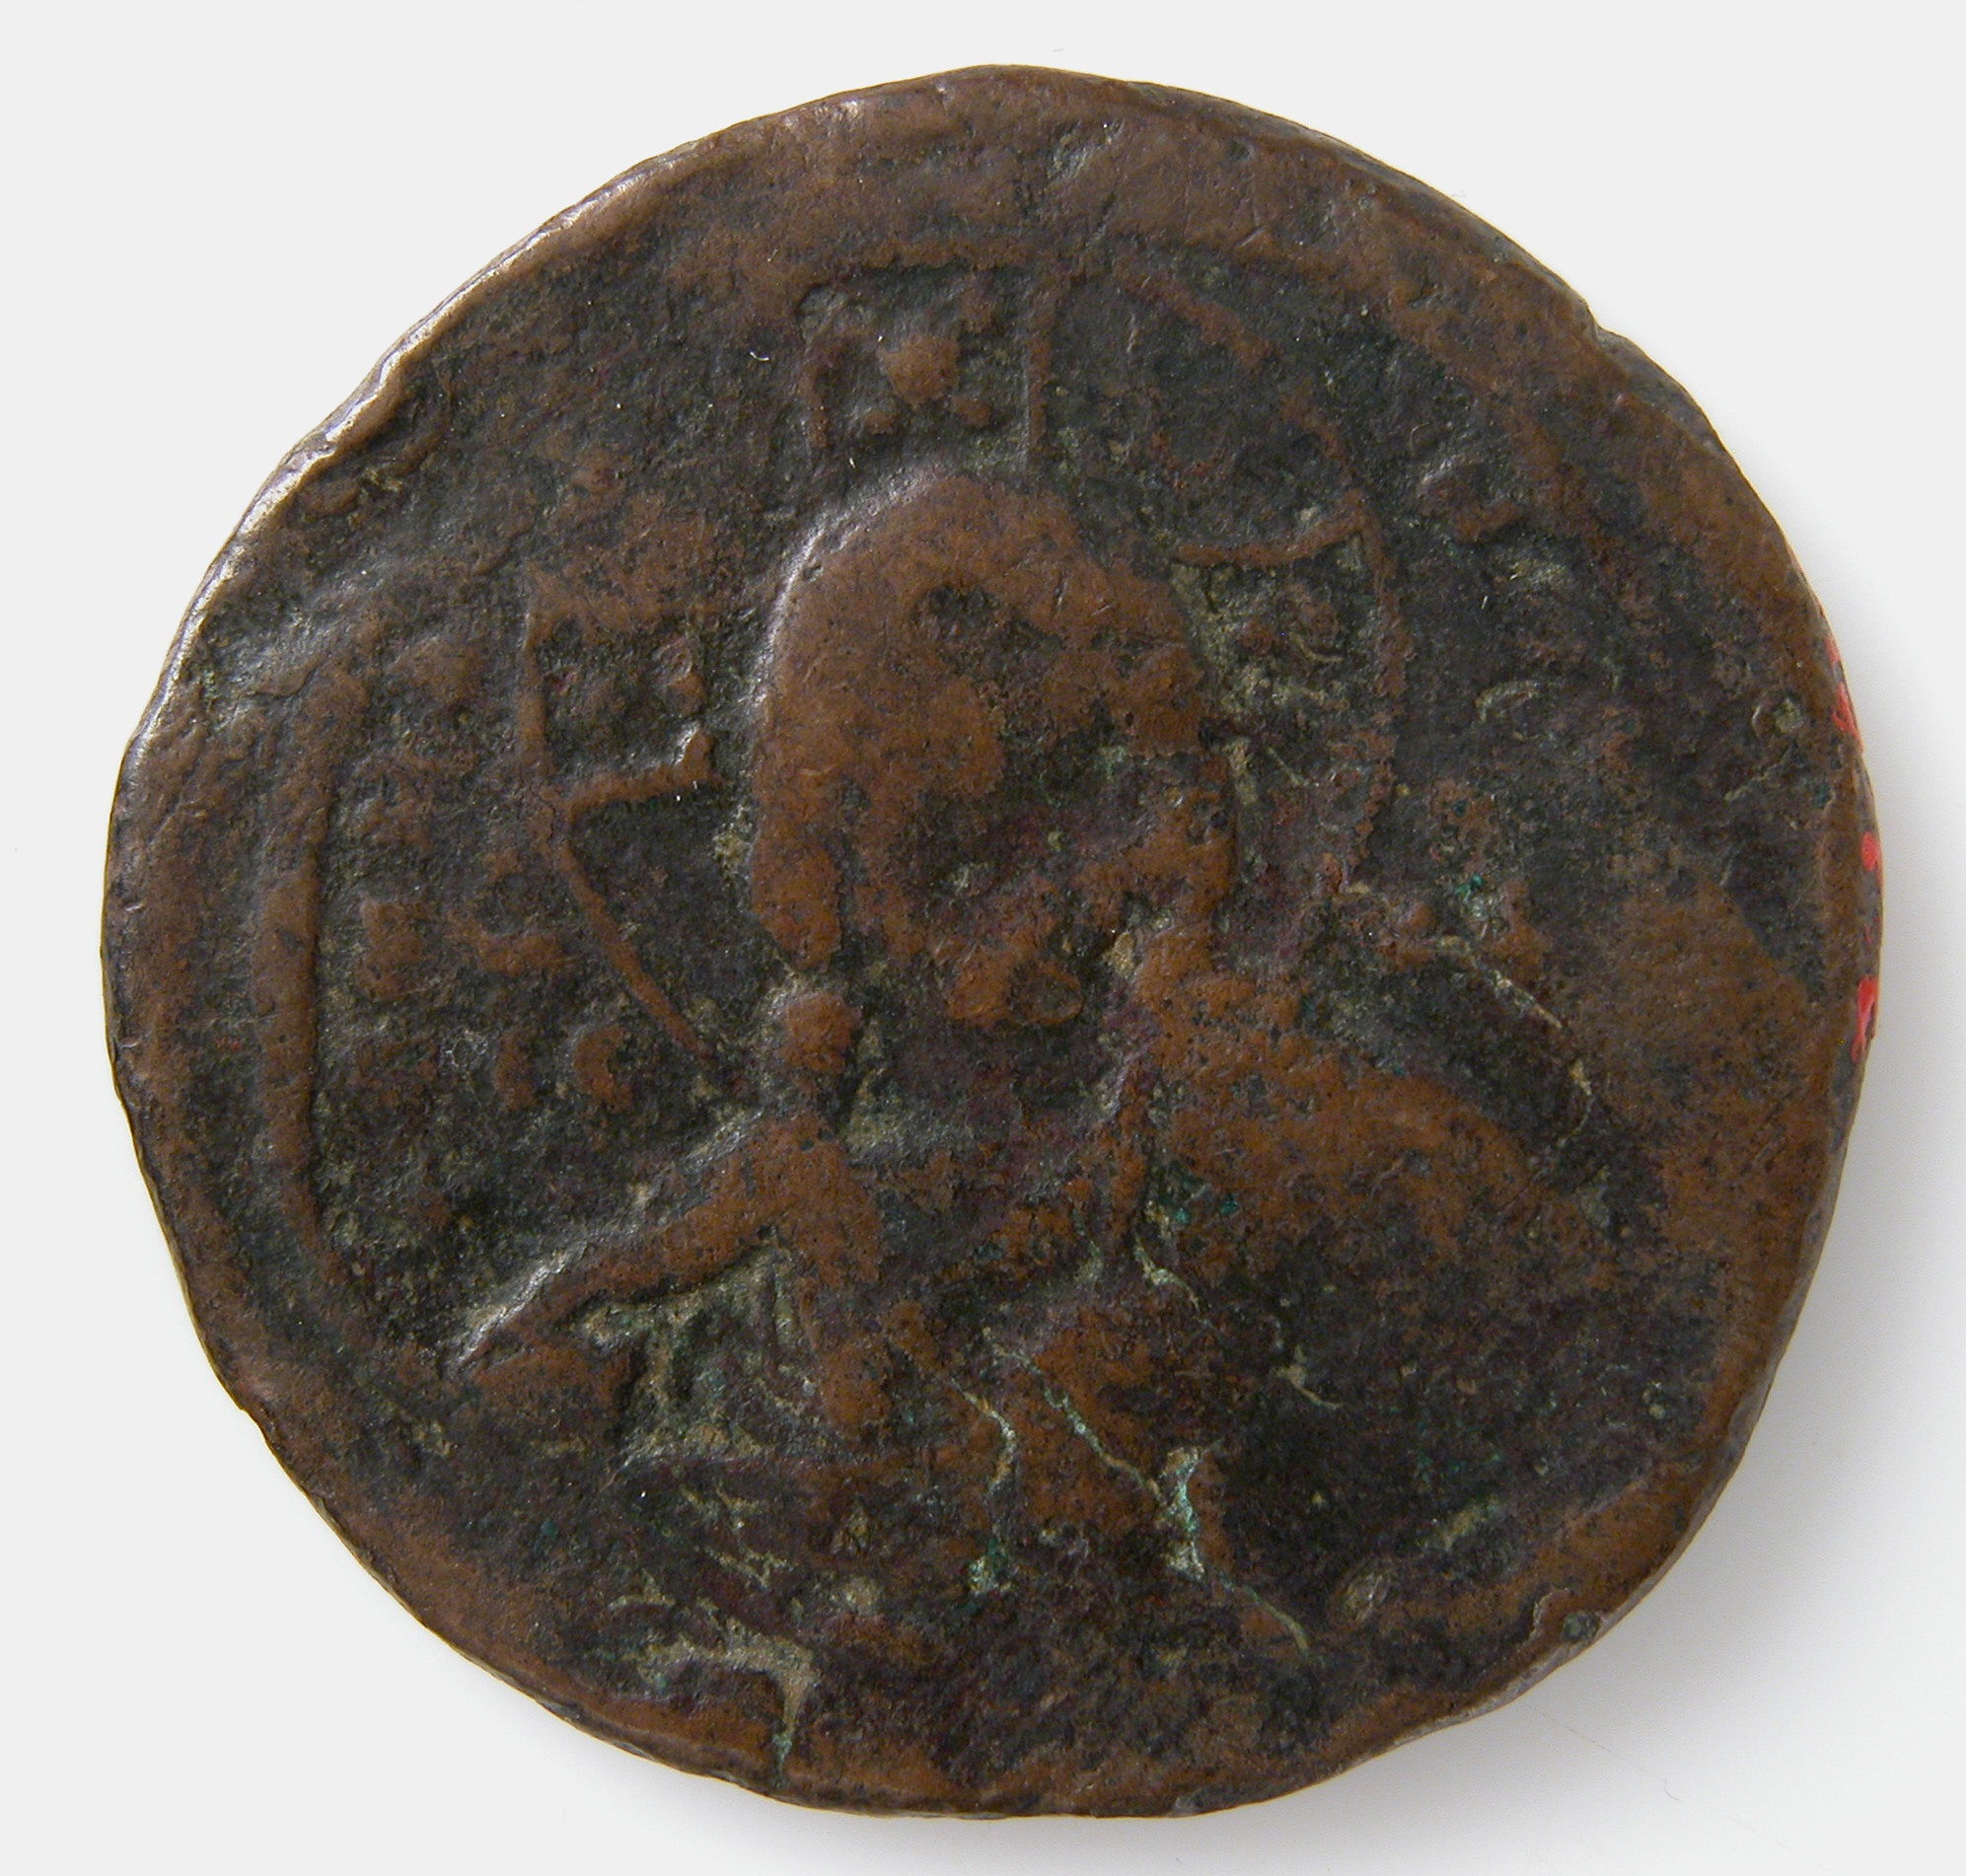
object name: coin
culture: byzantine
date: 976-1034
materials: copper alloy